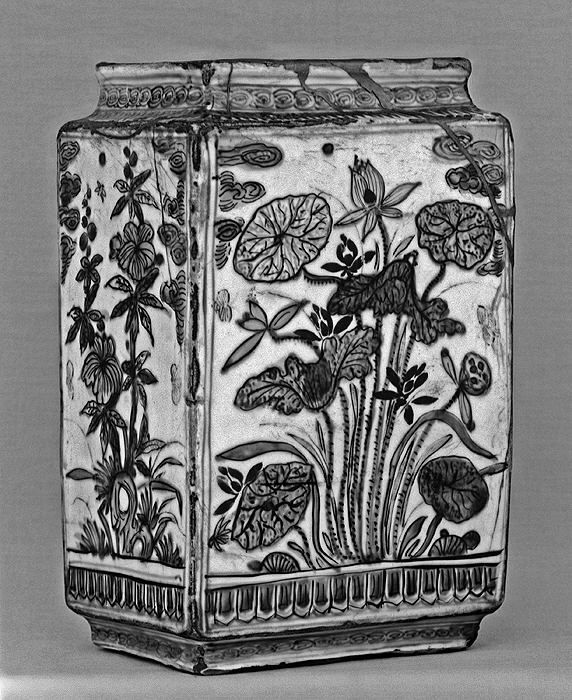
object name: vase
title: Vase with flowers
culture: china or japan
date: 1601-1700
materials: cobalt, enamel, gold, lacquer, porcelain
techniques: overglaze, painting, polychrome, underglaze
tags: flowers